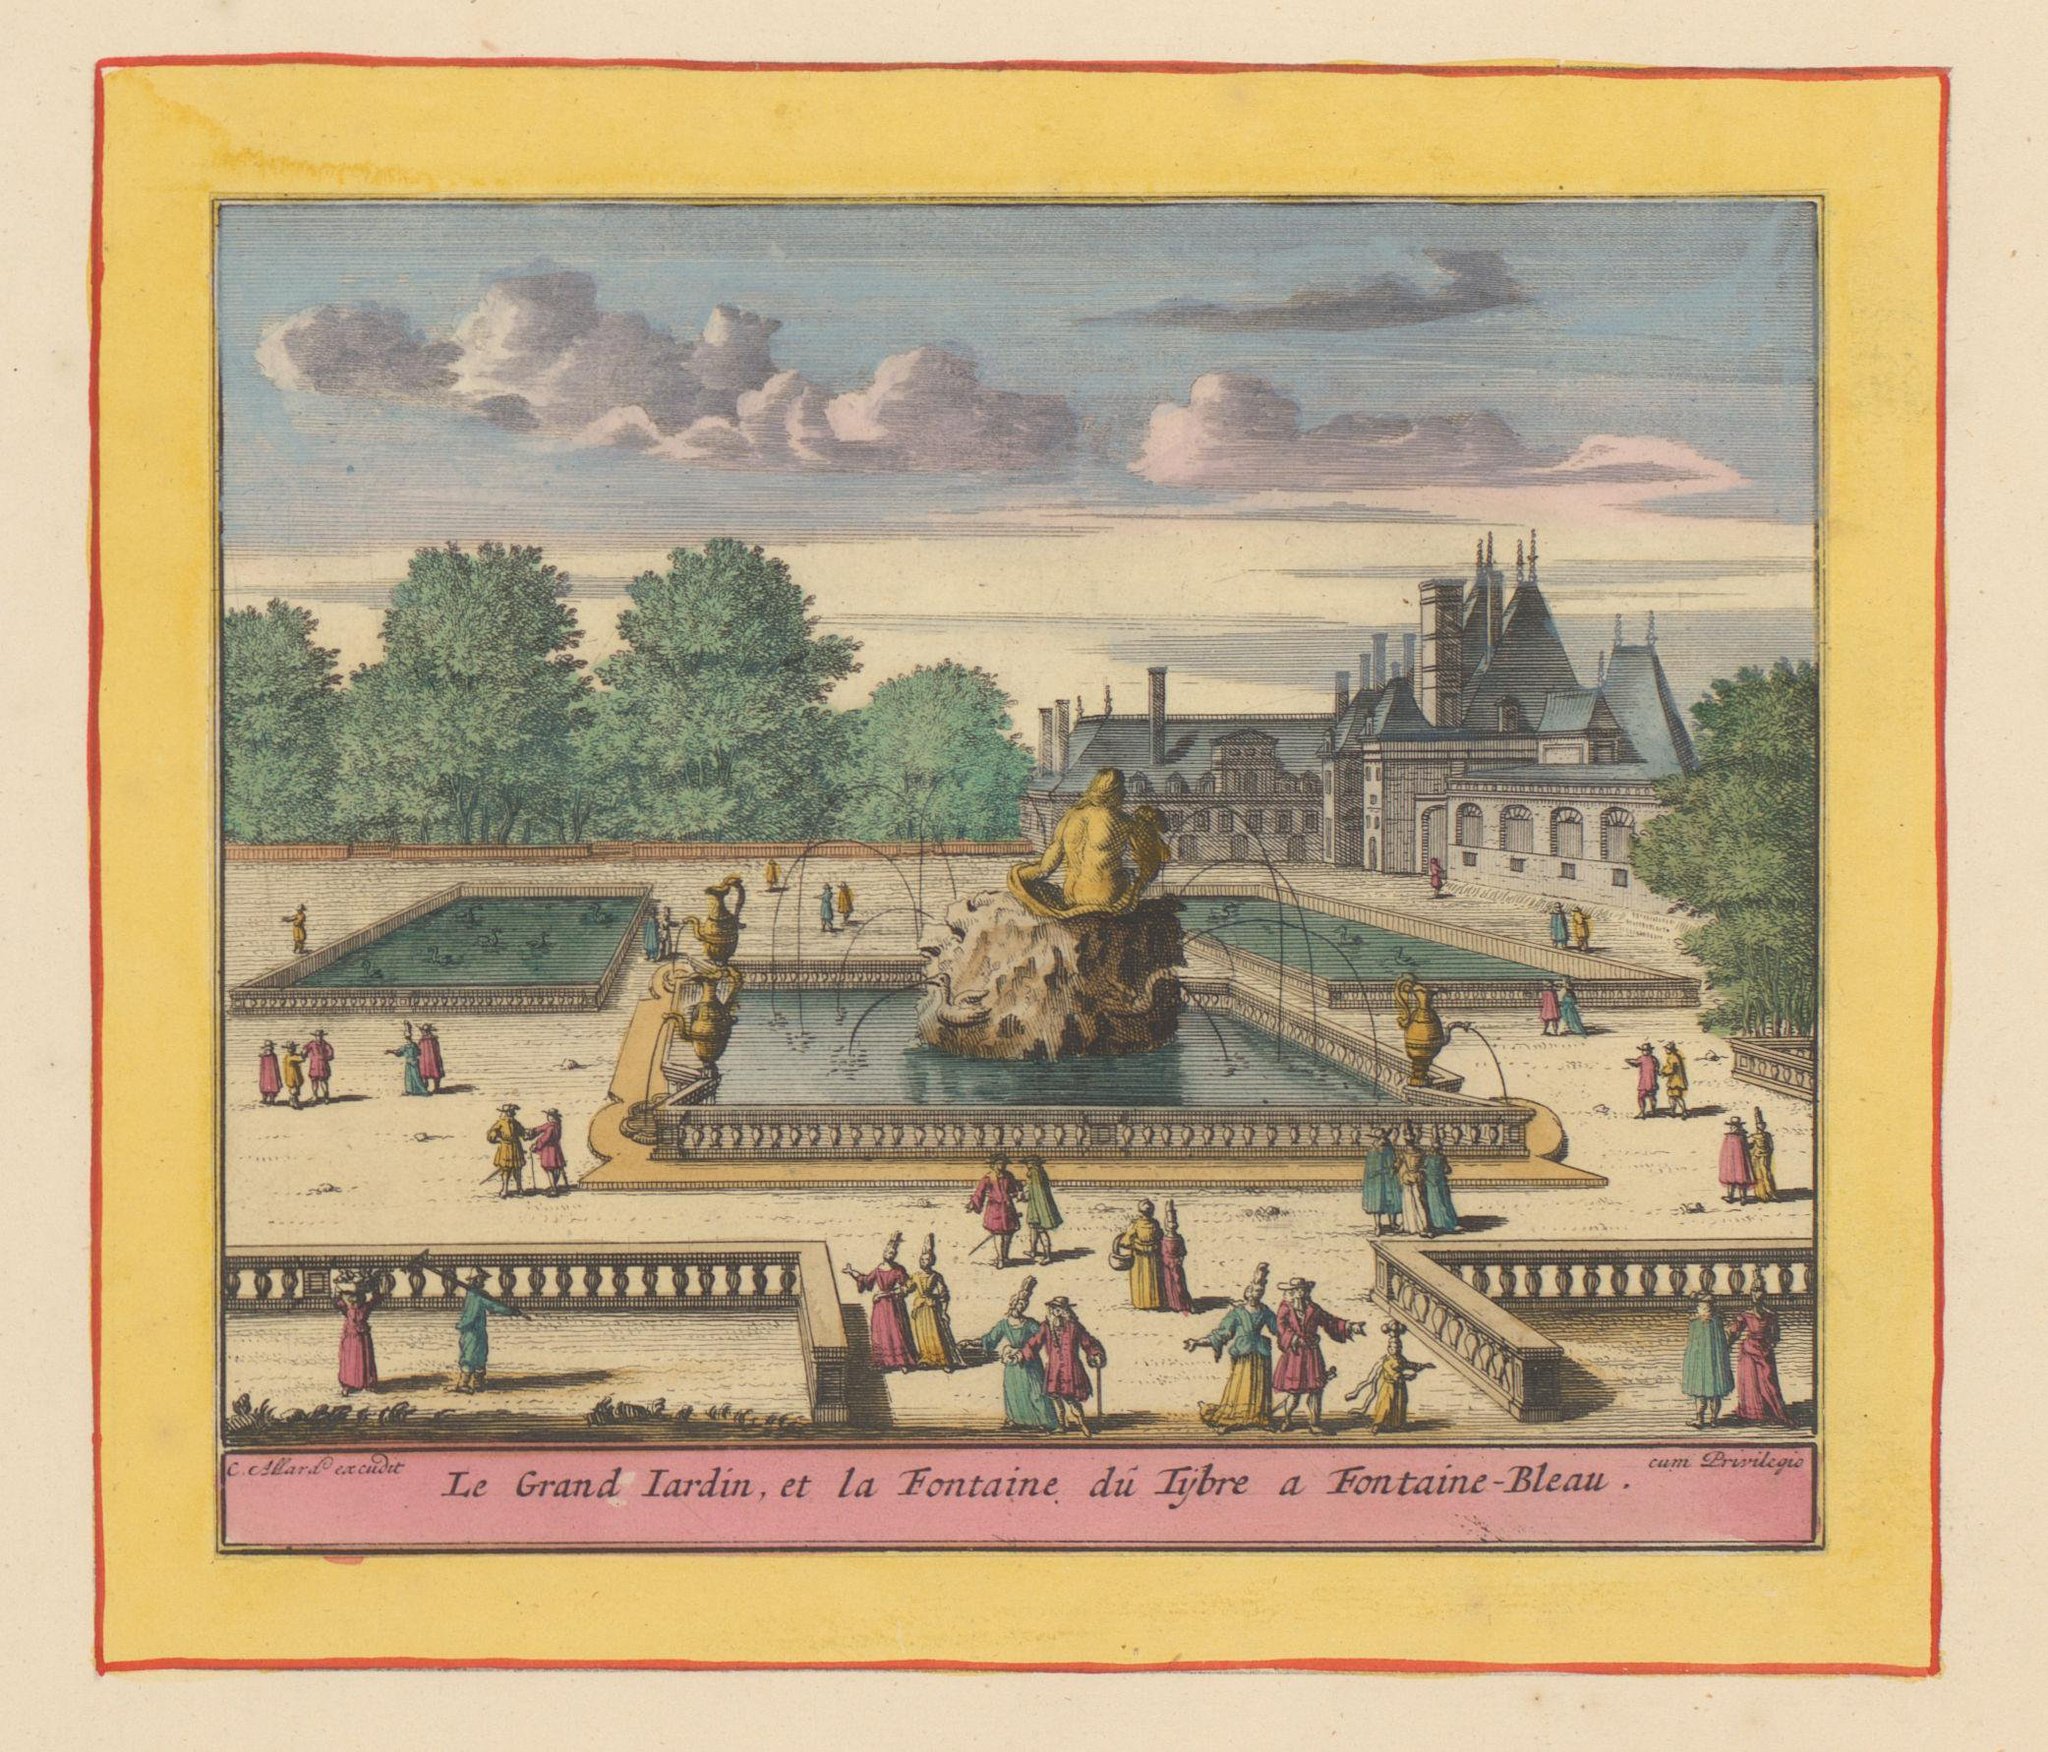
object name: album leaf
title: Le Grand Jardin, et la Fontaine du Tybre a Fontaine-Bleau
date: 1684-1709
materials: paper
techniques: etching, hand coloring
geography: amsterdam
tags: palace, french or architectonic garden; formal garden, courtyard, ornamental fountain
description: De Grand Jardin en het Bassin de Tibre in de tuin van het paleis van Fontainebleau. Rondom de fontein wandelen figuren. Prent maakt deel uit van een album.